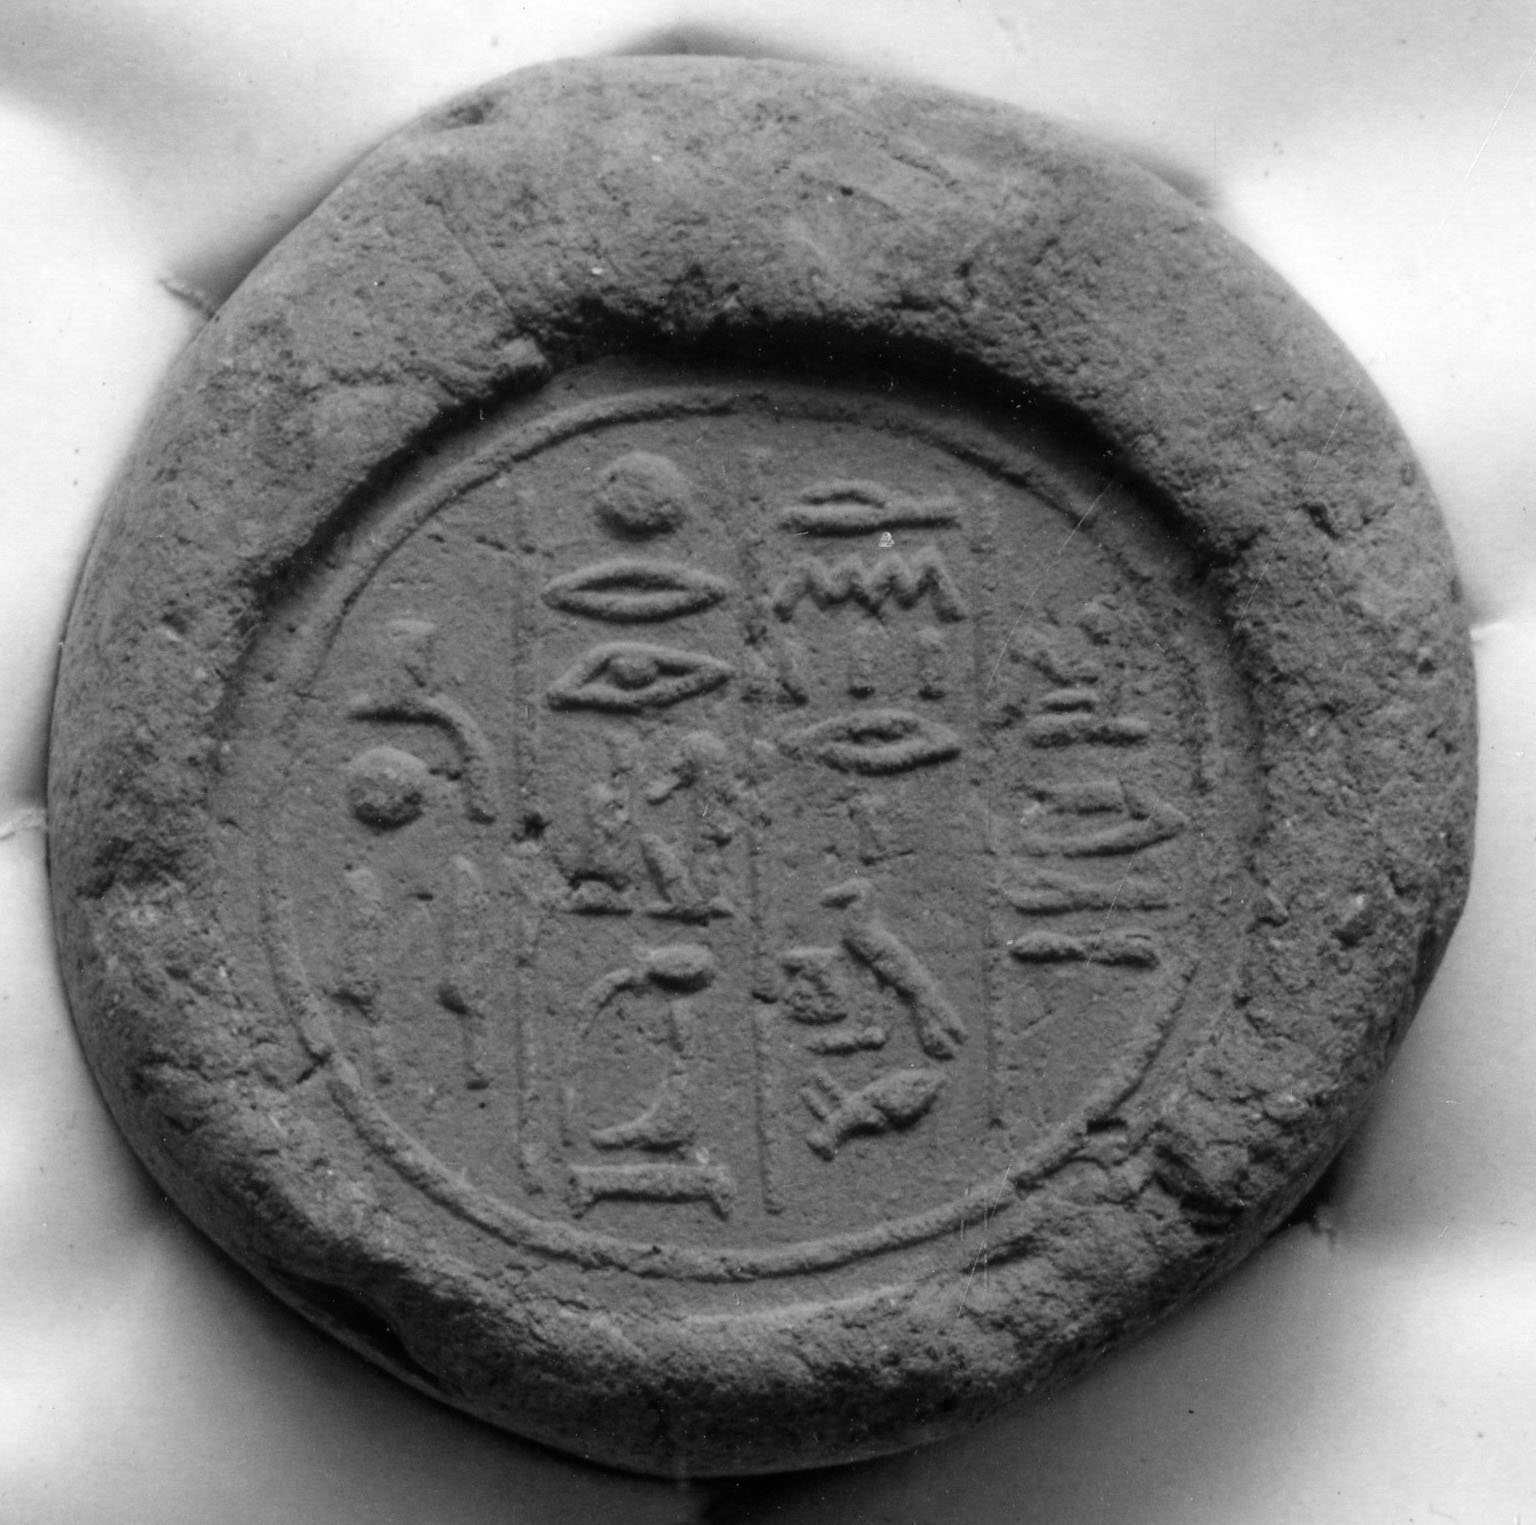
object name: cone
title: Funerary Cones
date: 1550-1295 BCE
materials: pottery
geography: egypt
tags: hieroglyphs